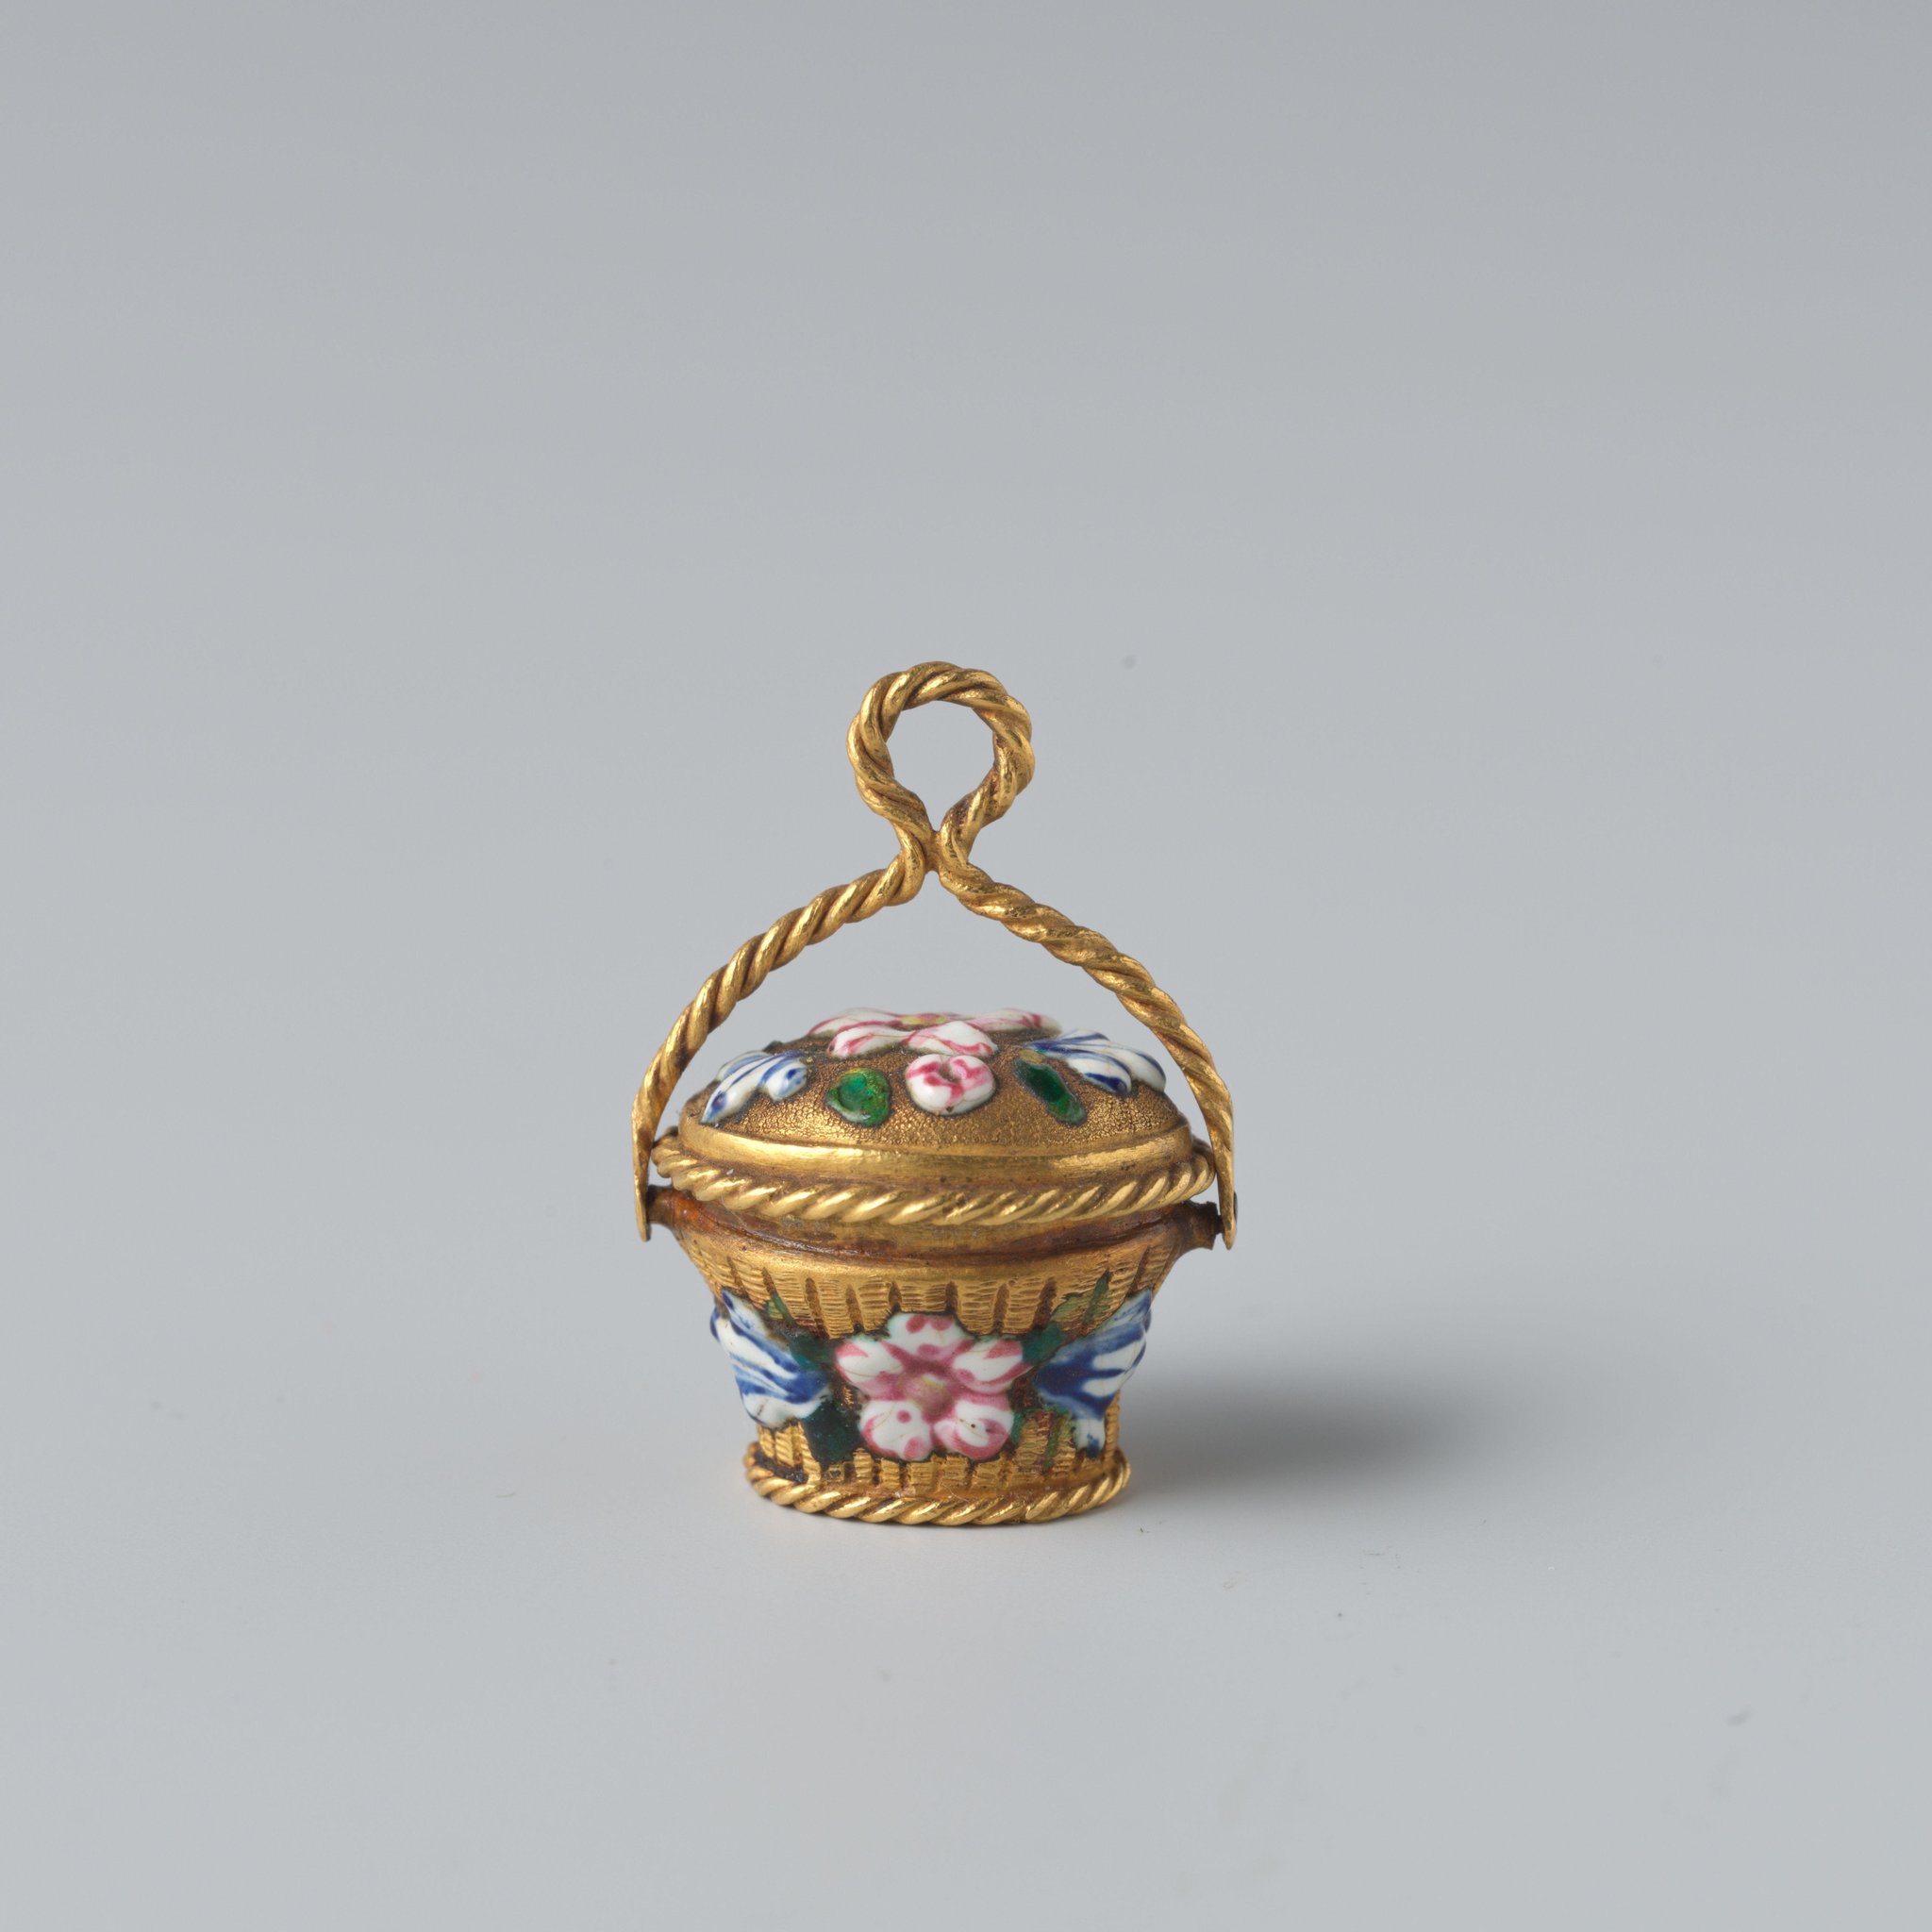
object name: basket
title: Doos in de vorm van een mand, met veelkleurige bloemdecoratie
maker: Anonymous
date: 1750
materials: gold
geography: london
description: Doos van goud in de vorm van een gevlochten mand, met scharnierend deksel en hengsel met ophang-oog. De mand en het gewelfde deksel zijn versierd met veelkleurige, emailbeschilderde bloemen, die in reliëf zijn aangebracht.